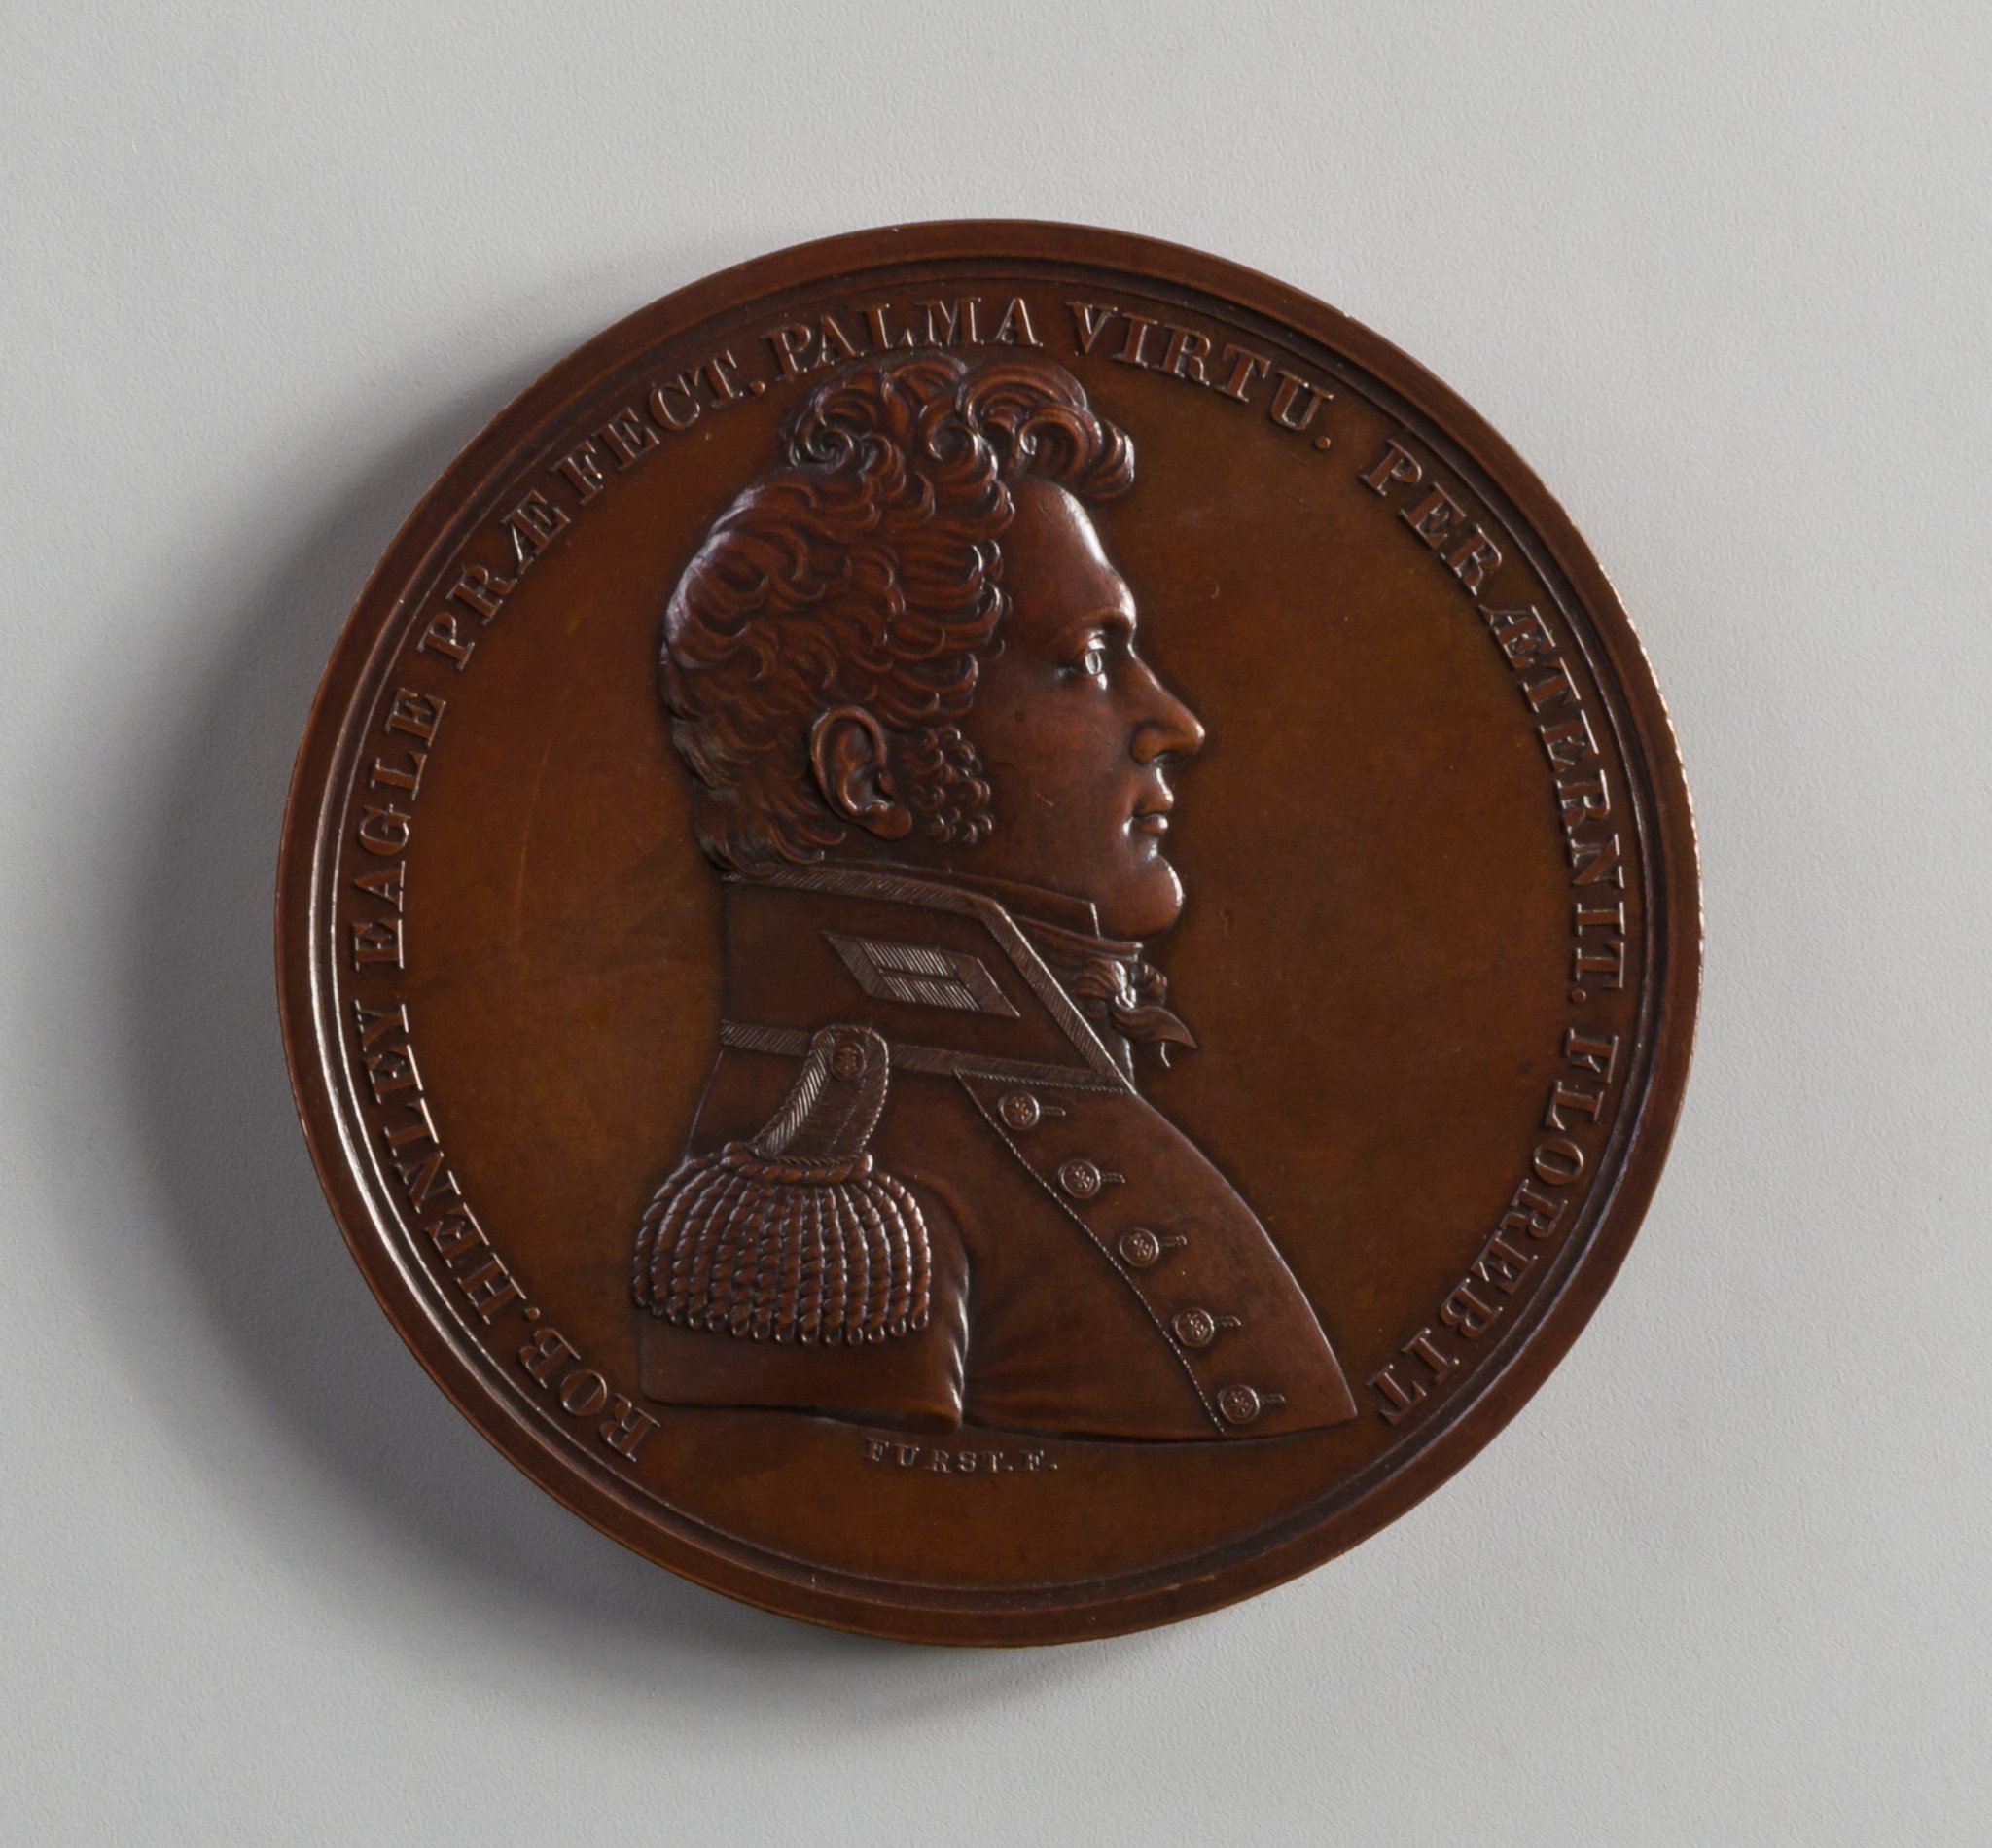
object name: medal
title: Medal of Captain Robert Henley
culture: american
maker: moritz fürst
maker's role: maker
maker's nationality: hungarian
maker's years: 1782-1882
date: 1814-1815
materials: bronze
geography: united states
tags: men,portraits,profiles